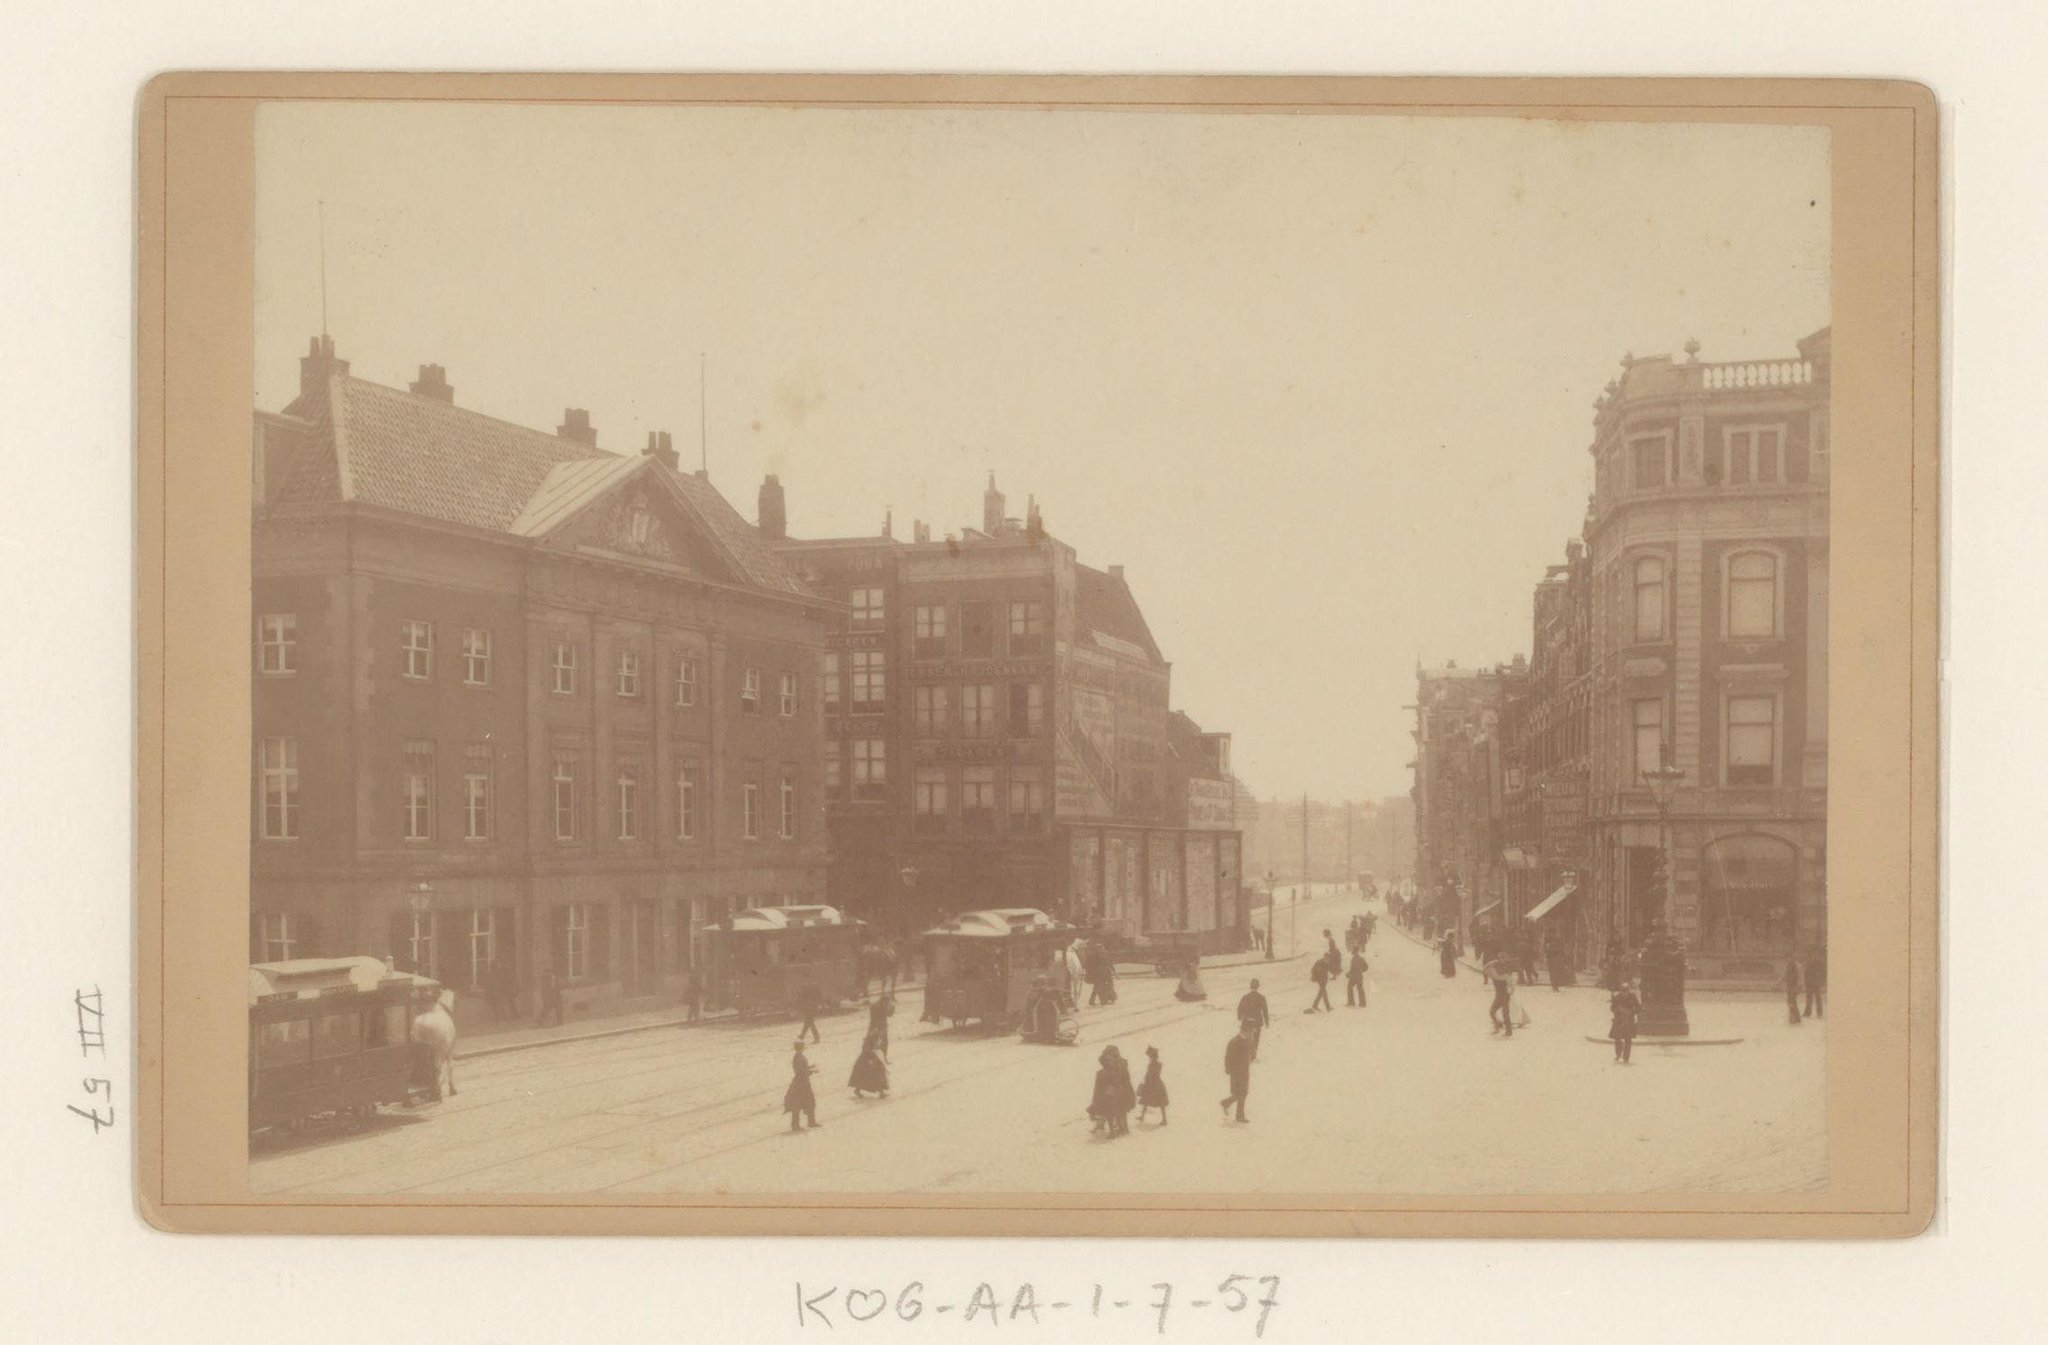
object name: cabinet photograph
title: Gezicht op de Dam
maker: Anonymous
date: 1860-1900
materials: cardboard, paper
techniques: albumen print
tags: square, place, circus, etc., city-view in general; 'veduta', façade (of house or building)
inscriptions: collector's mark: ‘7’ Lugt 1641b, inscription: ‘Dam’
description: Onderwerpsrubriek binnen de Atlas Amsterdam: Dam (na 1835).